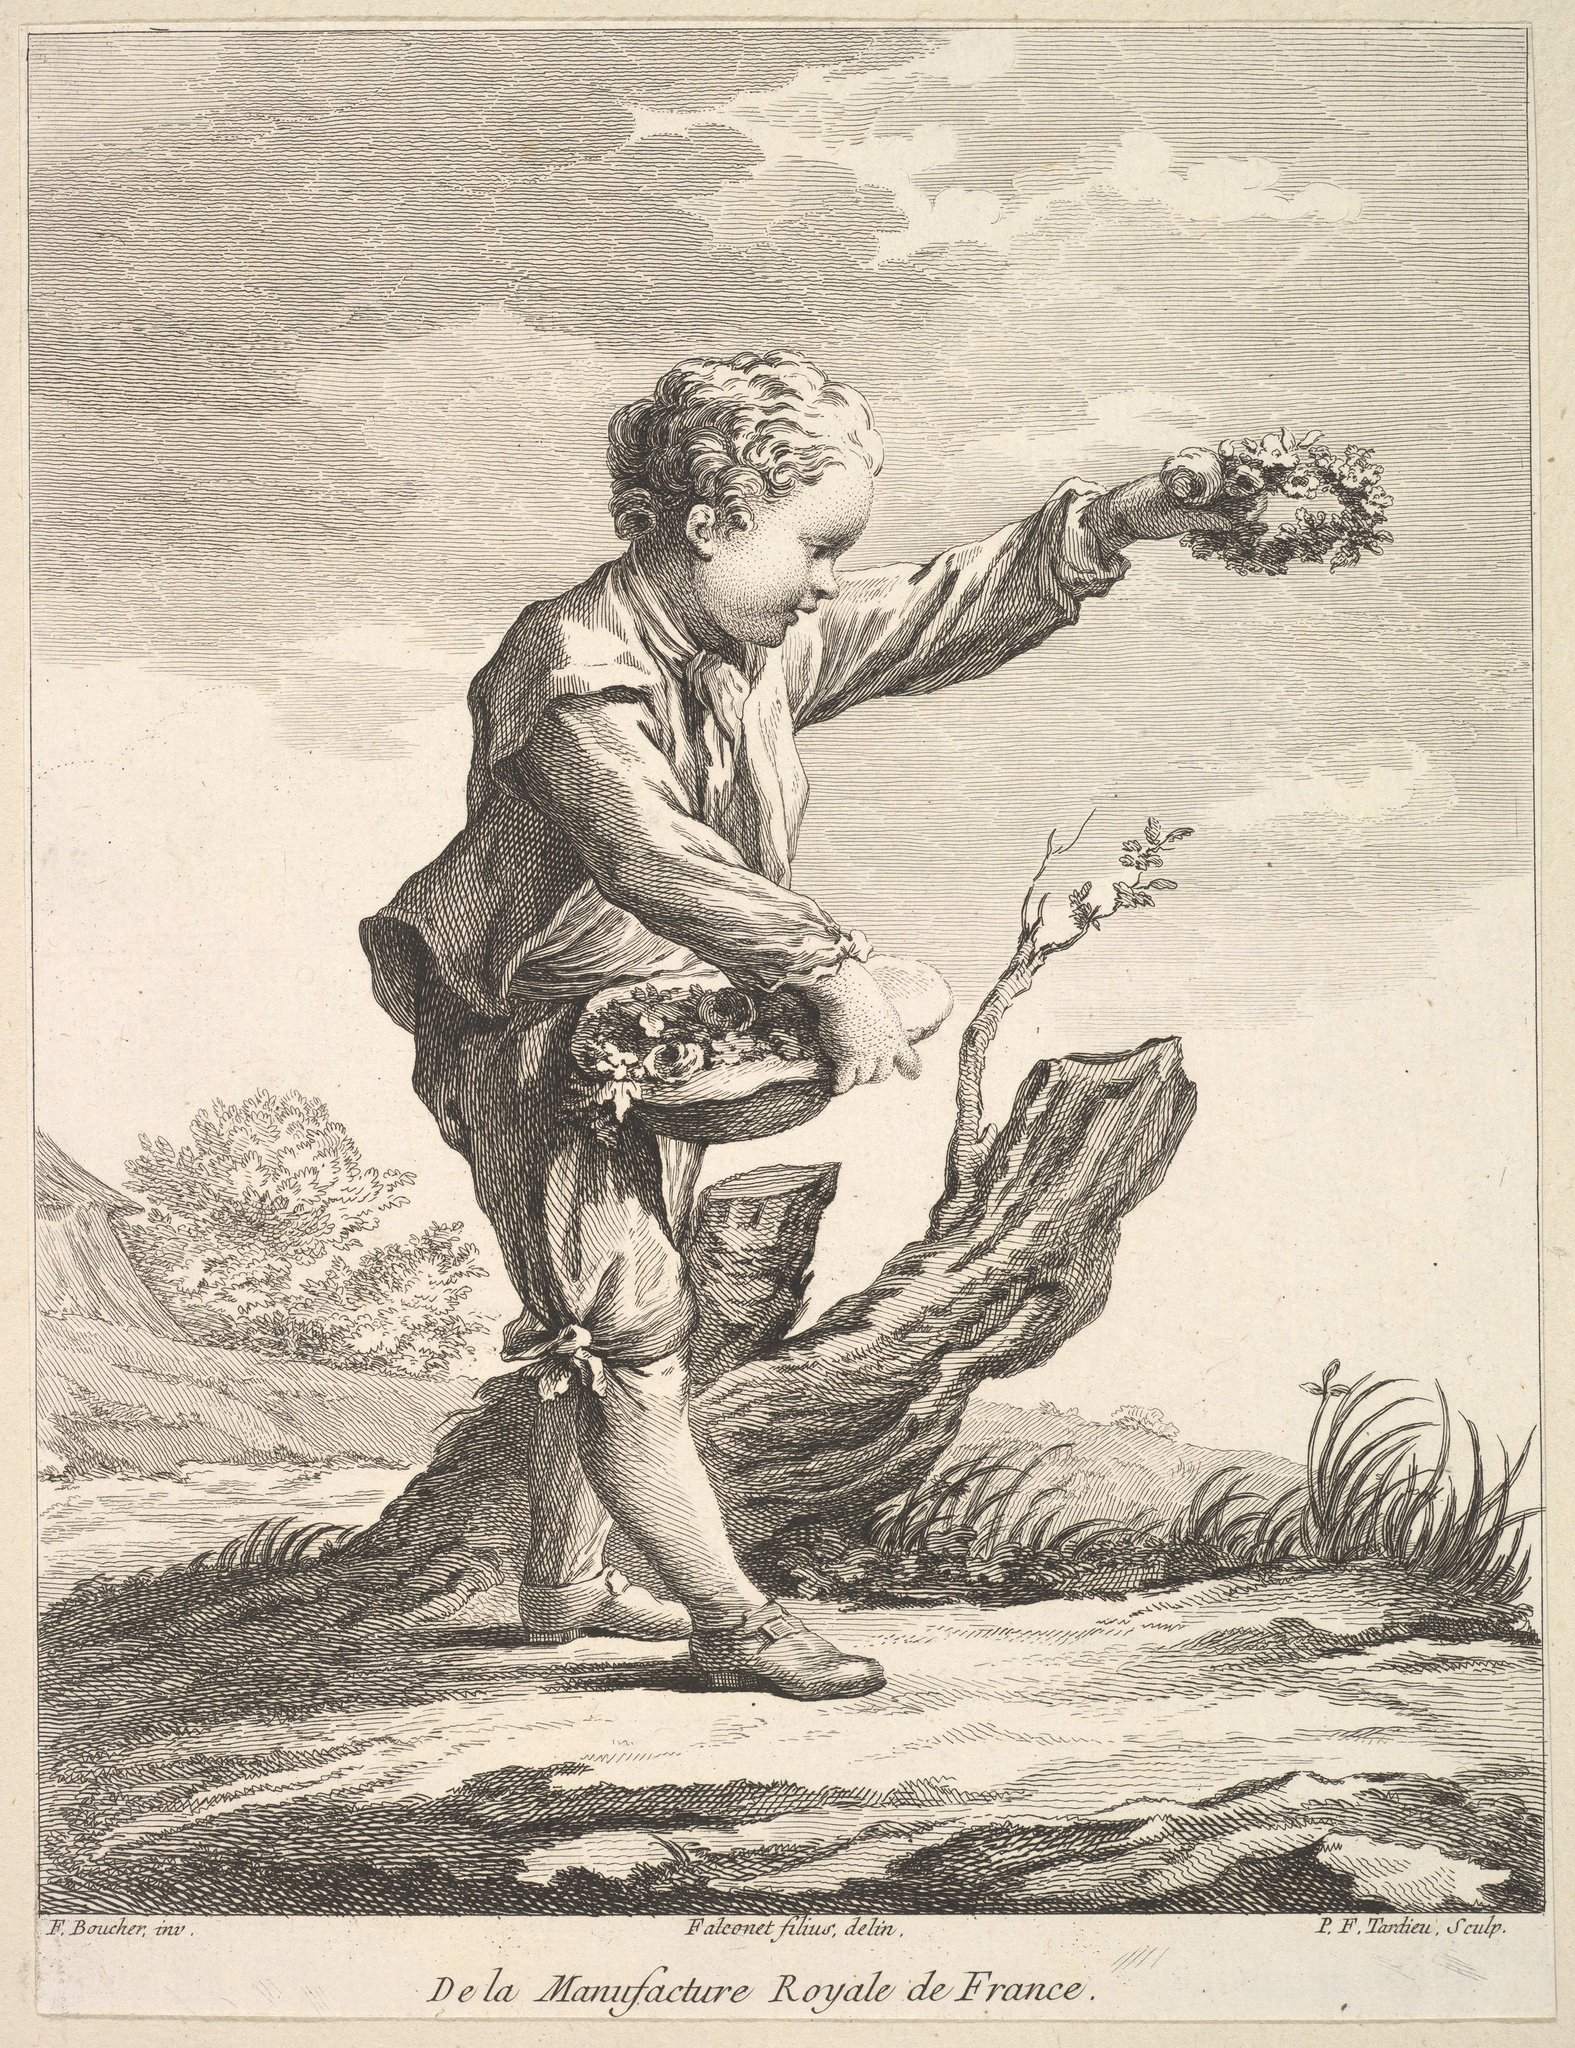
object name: collection ornament architecture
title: Little boy holding a wreath and basket of flowers, from Deuxième Livre de Figures d'après les porcelaines de la Manufacture Royale de France (Second Book of Figures after porcelains from the Manufacture Royale de France)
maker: pierre françois tardieu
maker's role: artist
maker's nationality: french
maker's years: 1711-1771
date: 1757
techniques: engraving, etching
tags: boys,flowers,wreaths